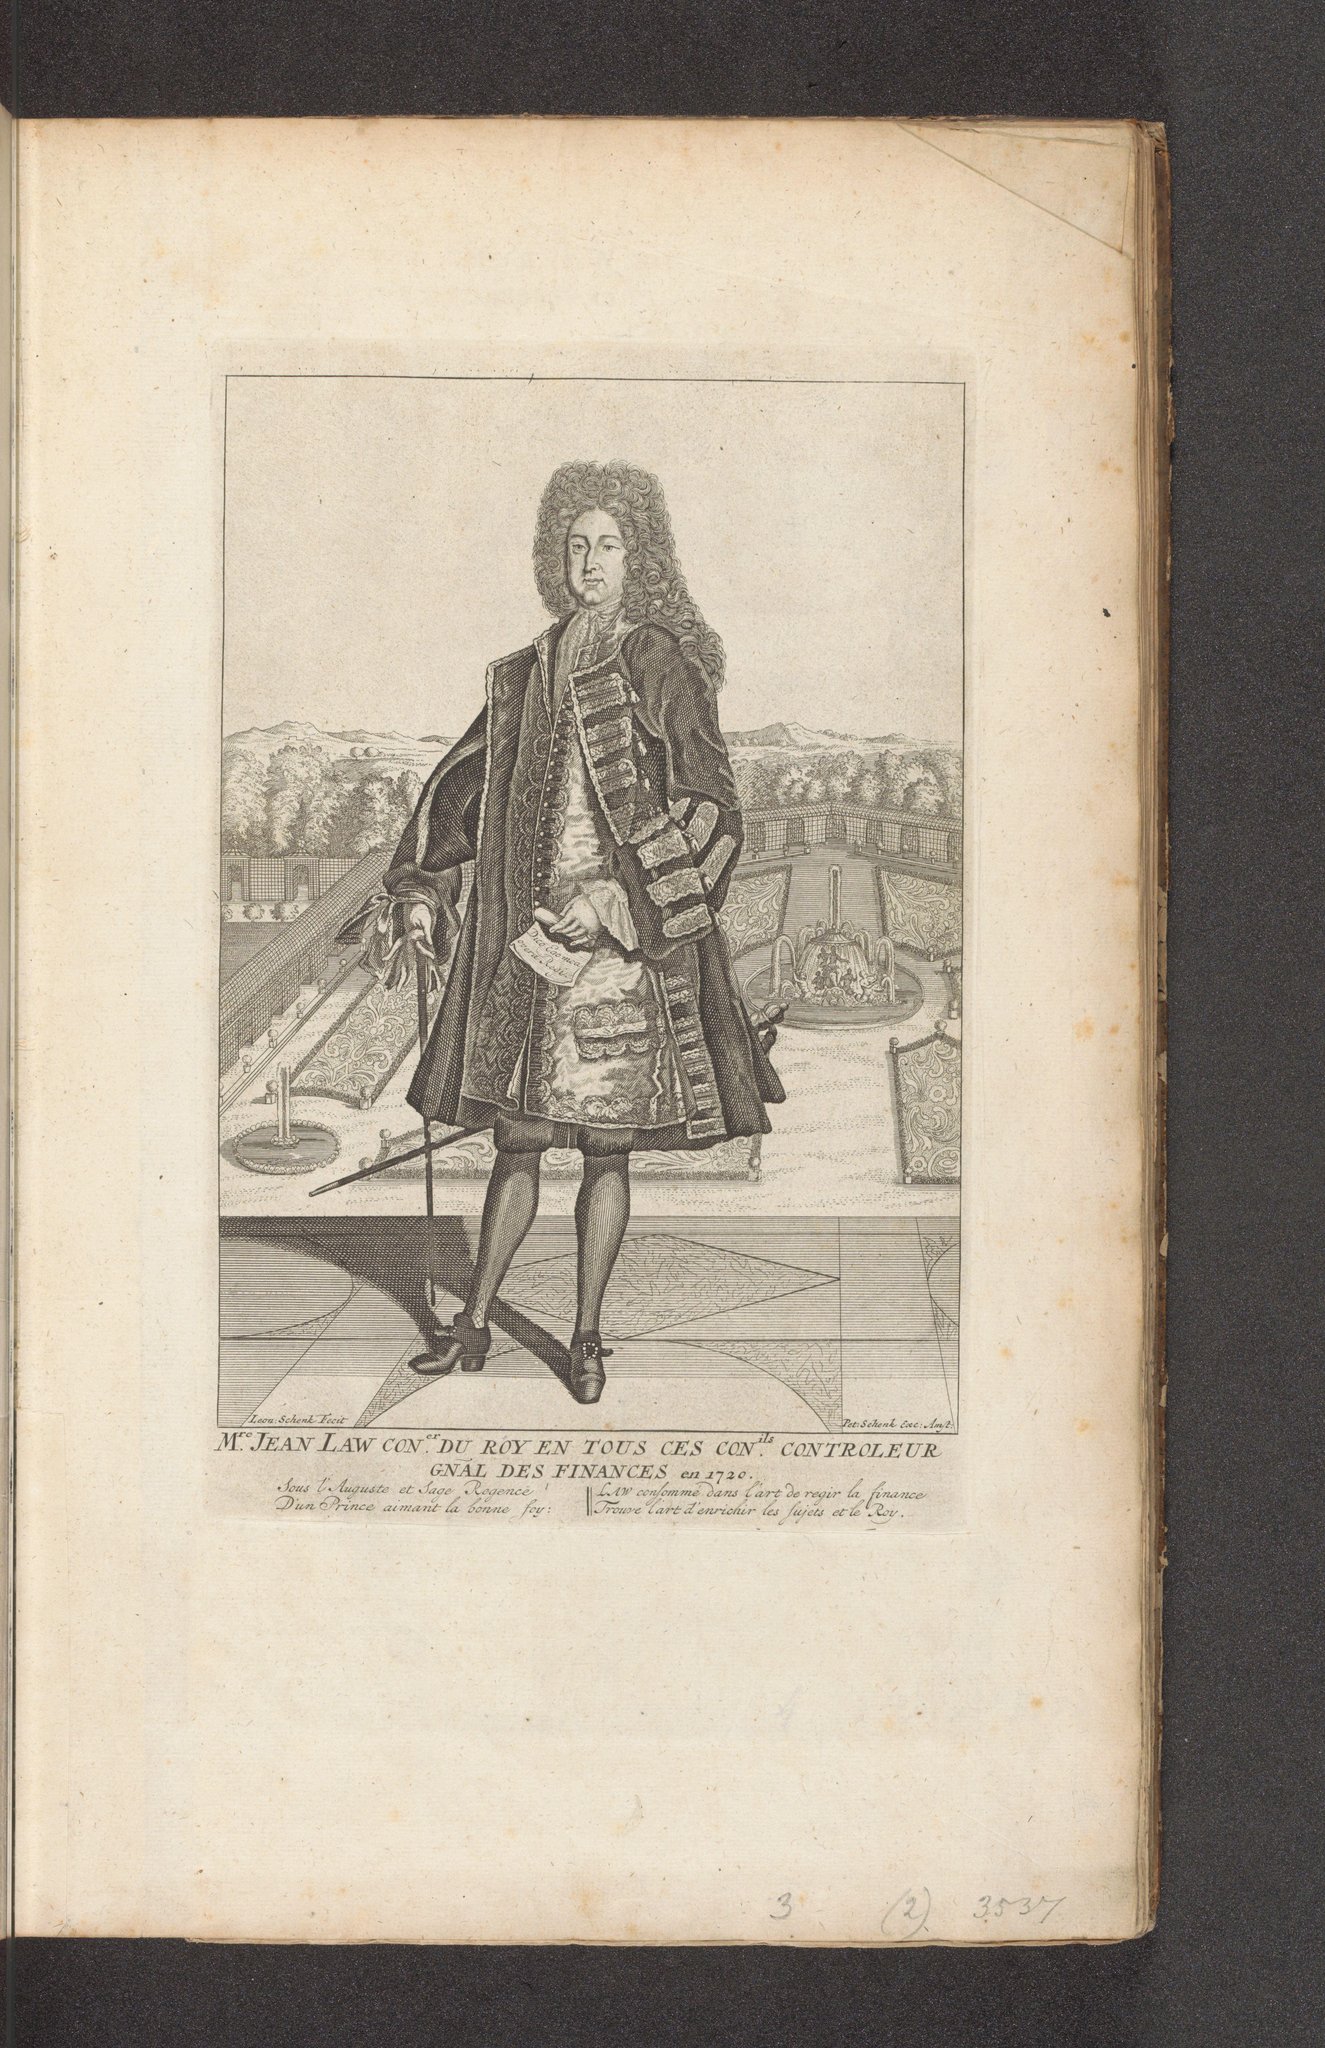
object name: print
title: Mre. Jean Law con.er du roy en tous ces con.ils controleur gnal des finances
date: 1720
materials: paper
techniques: etching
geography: amsterdam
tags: econoom, john law, windhandel van 1720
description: Portret van John Law, staande ten voeten uit, op de achtergrond een tuin met fontein. In het onderschrift een vierregelig vers in het Frans. Blad in de gebonden vierde uitgave (304 B 12) van Het Groote Tafereel der Dwaasheid met spotprenten op de Windhandel of Actiehandel van 1720.